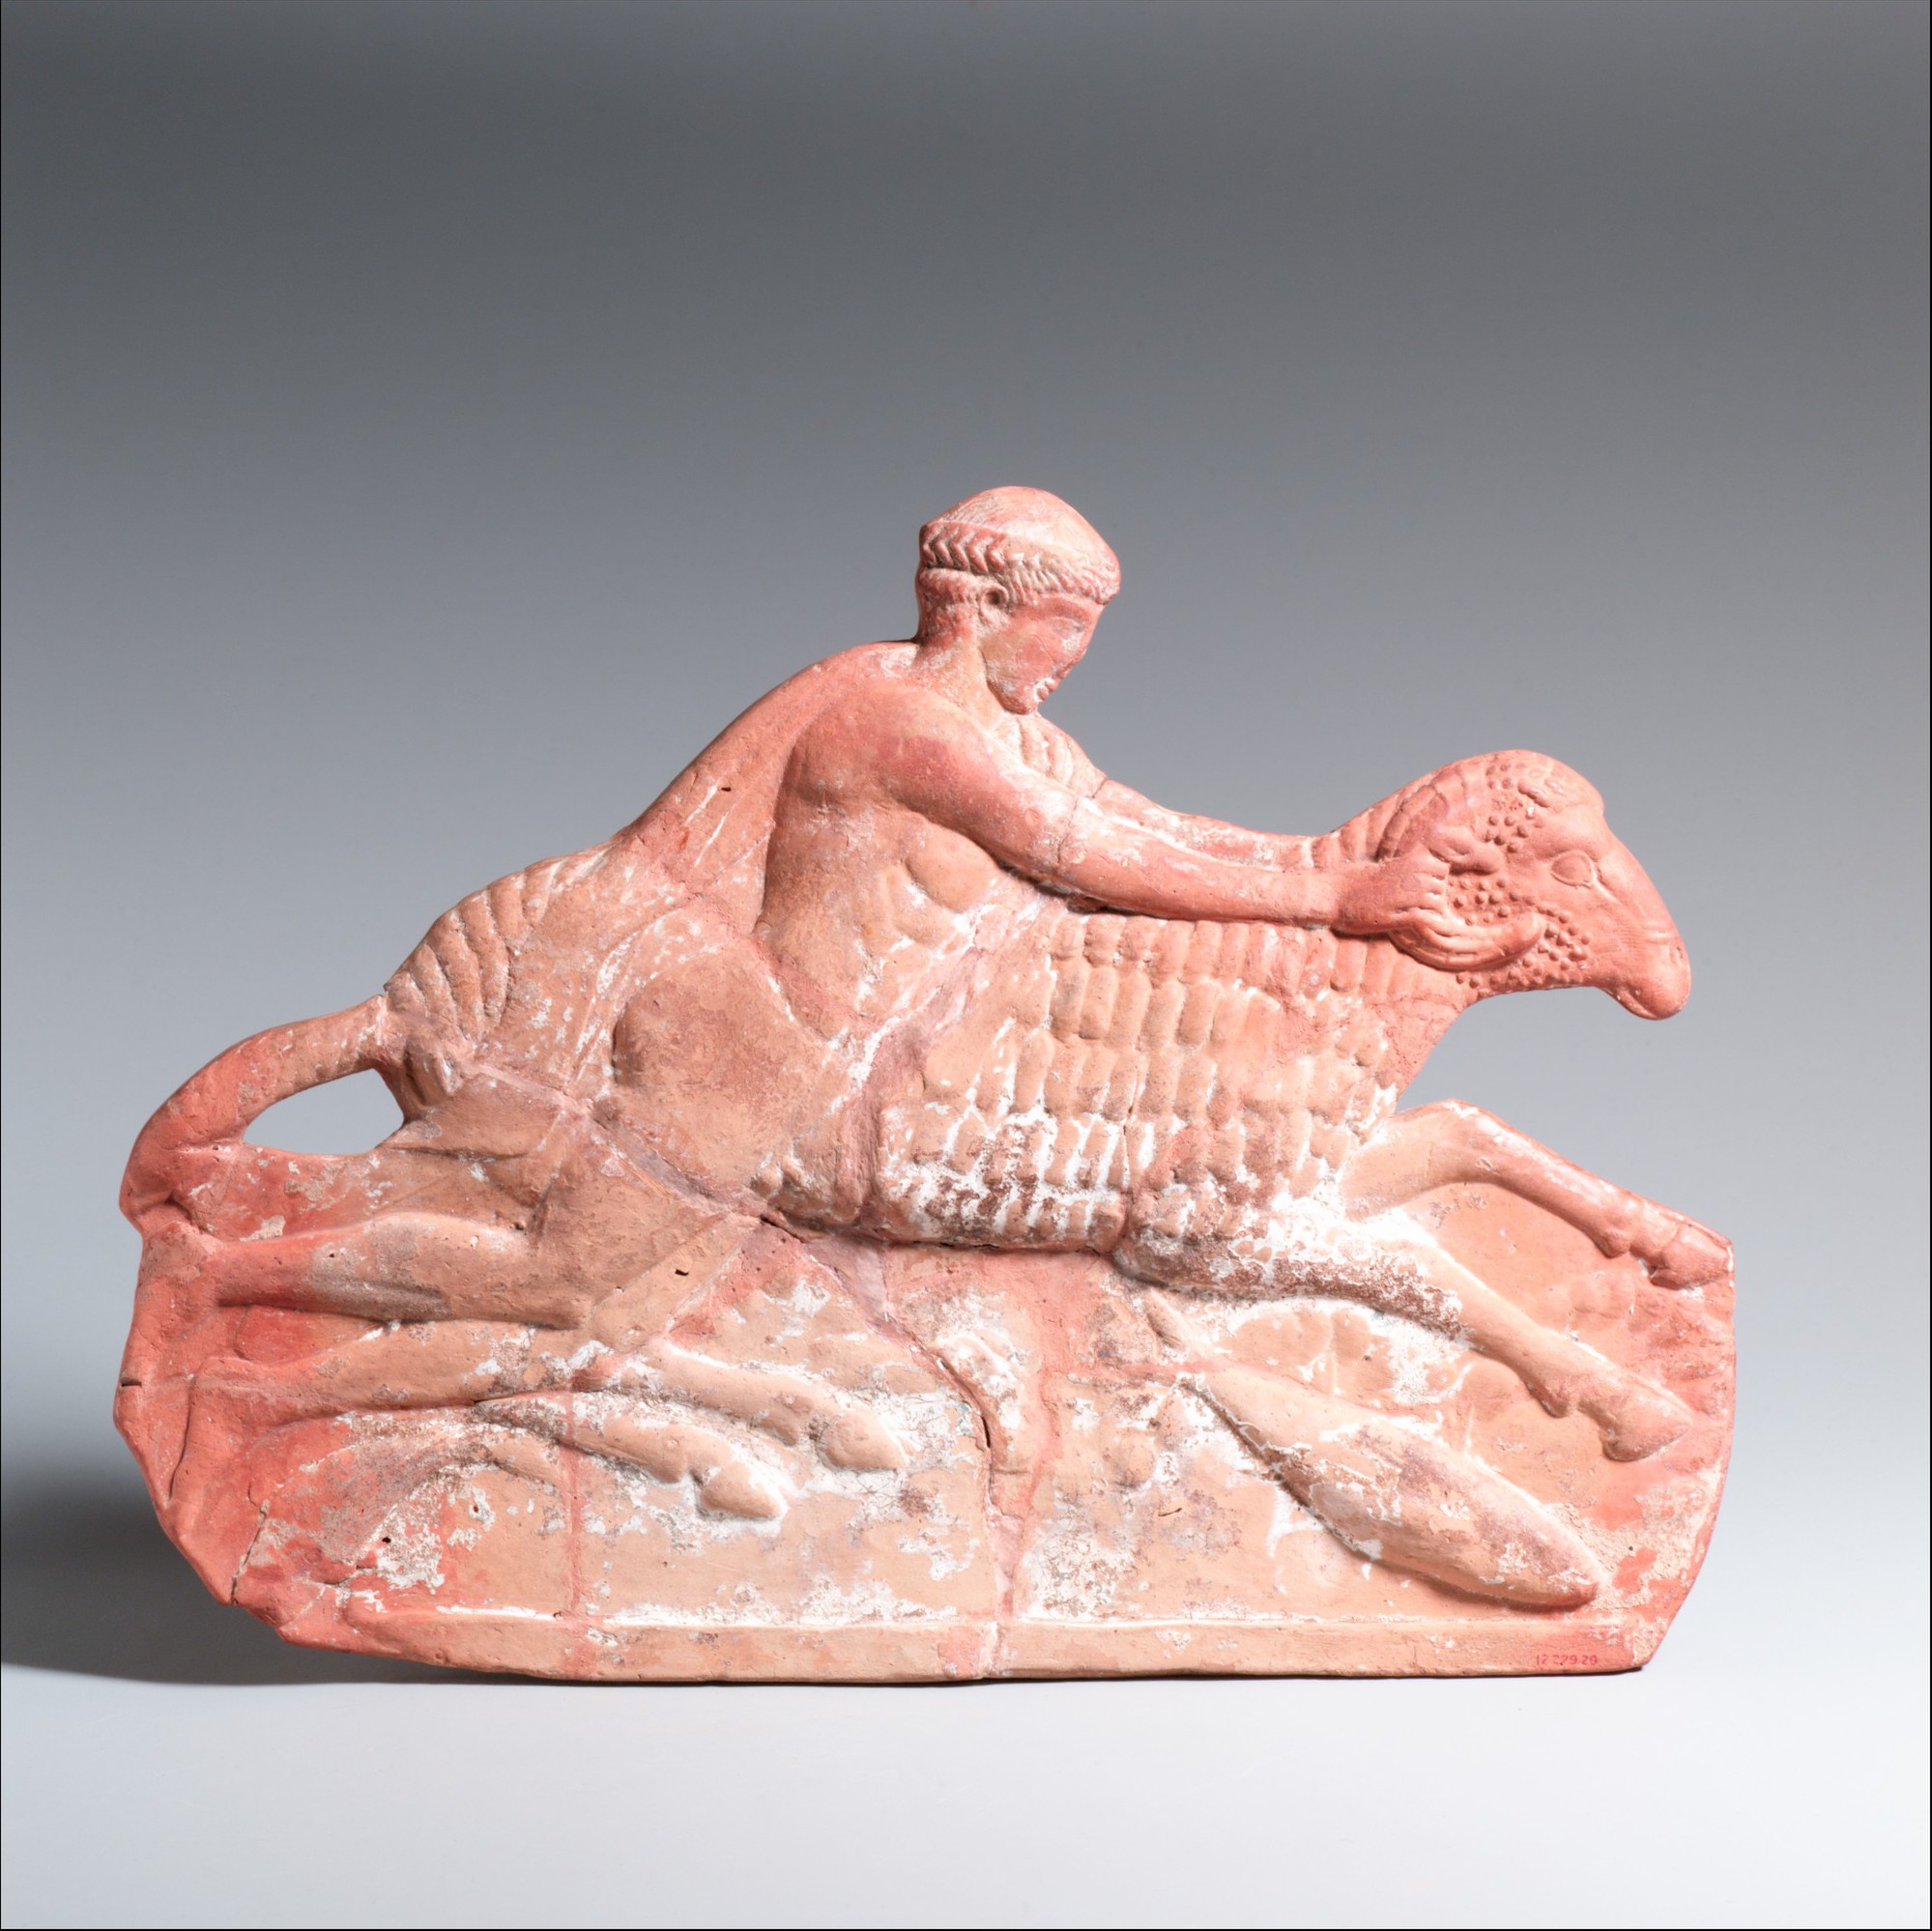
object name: relief of phrixos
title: Terracotta plaque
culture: greek, melian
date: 450 BCE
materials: terracotta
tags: men,rams